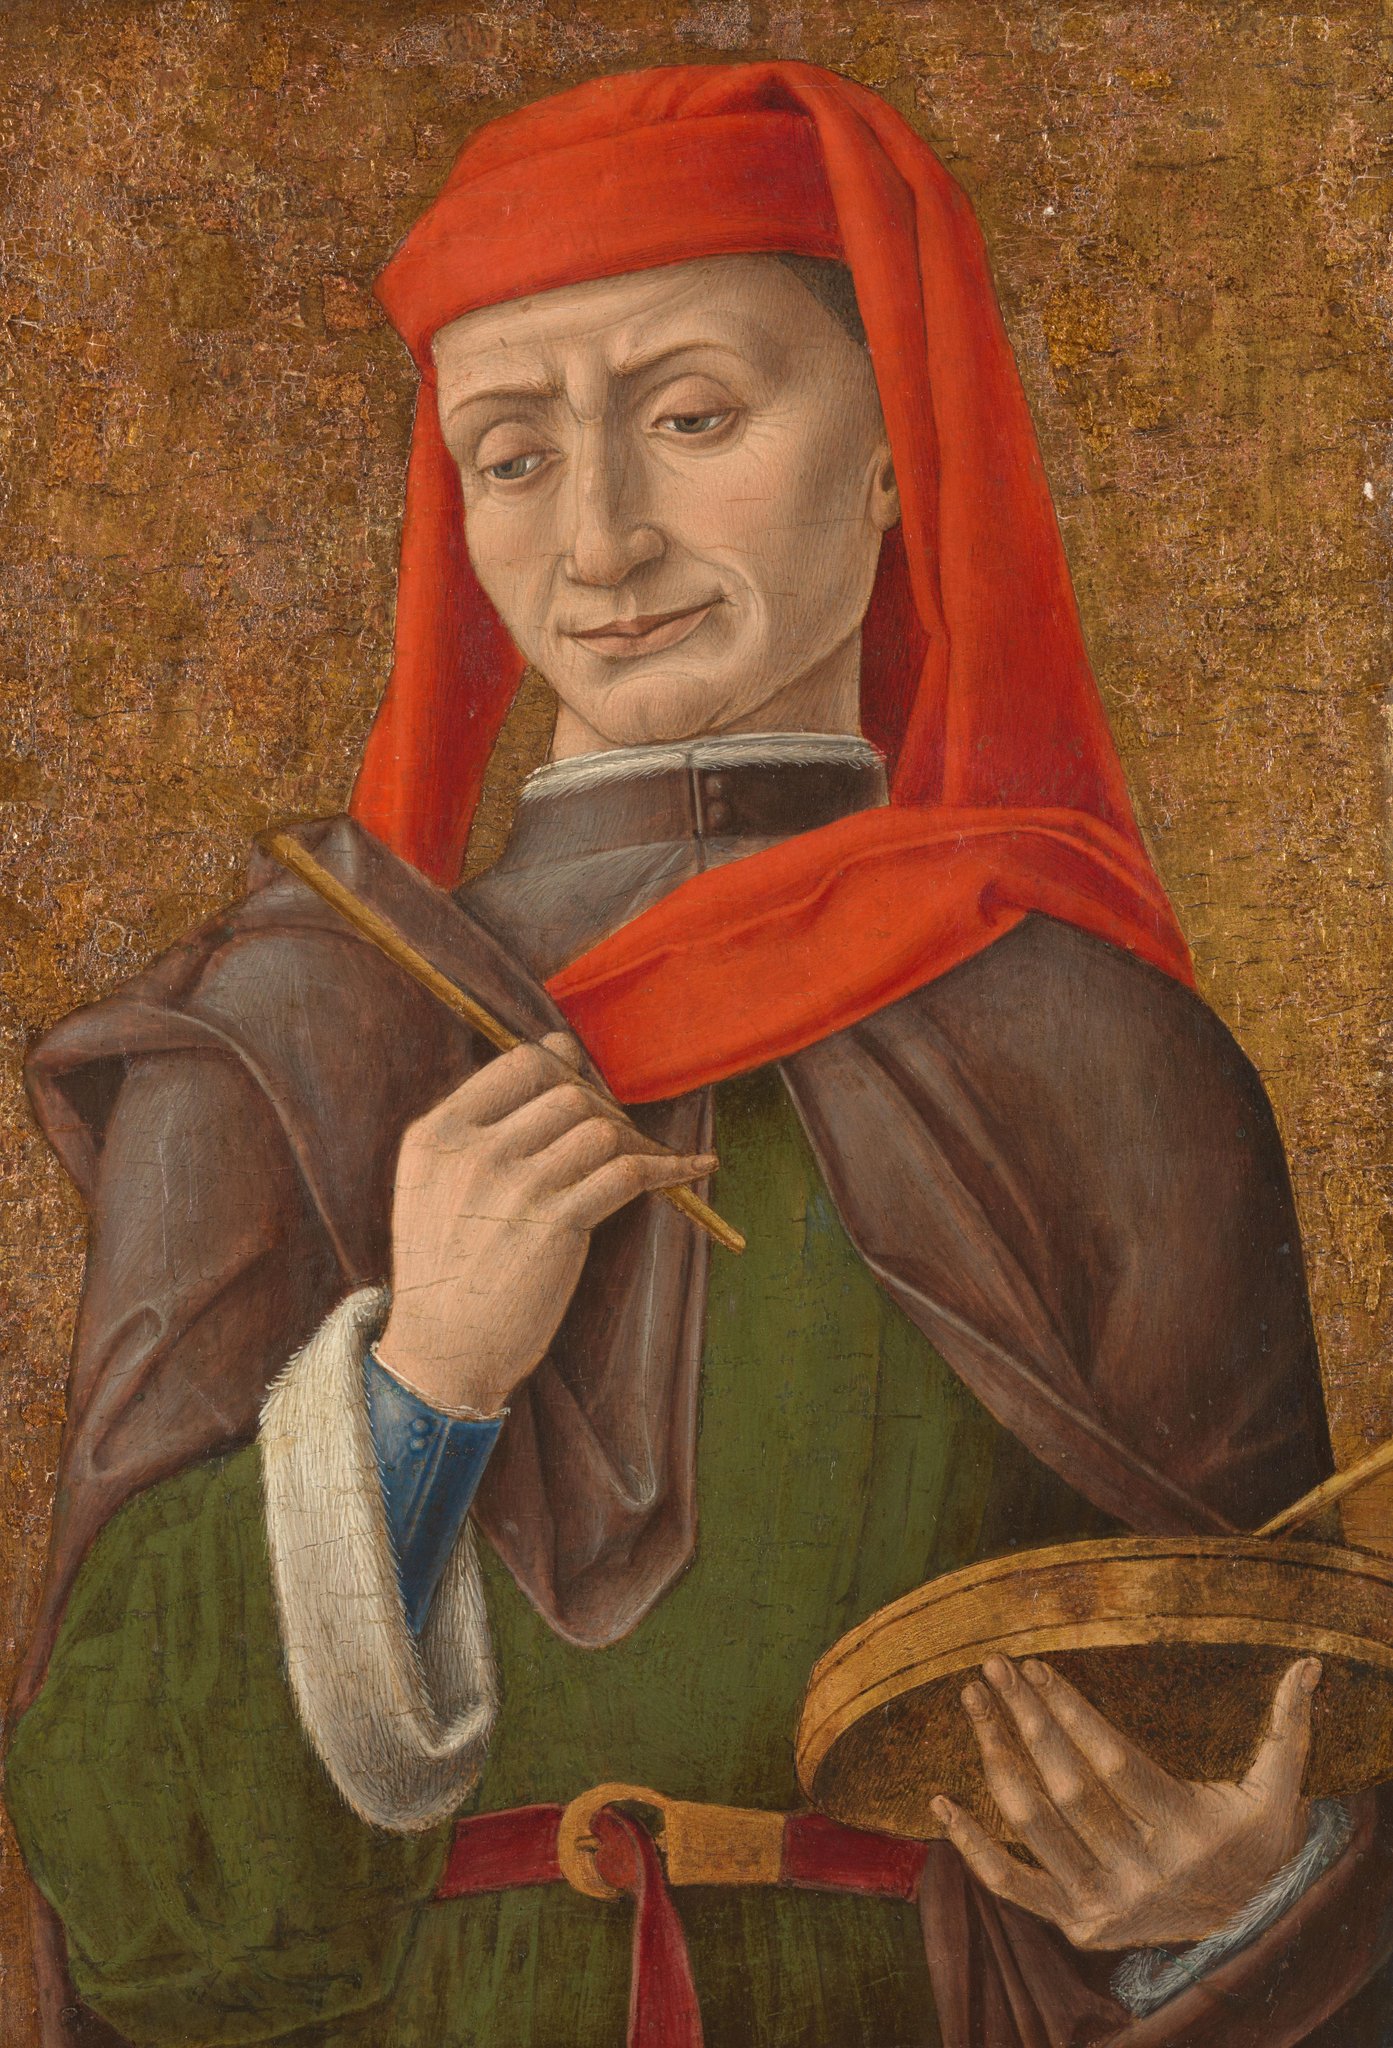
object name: painting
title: Saint Damian (or Cosmas)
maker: bartolommeo vivarini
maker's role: painter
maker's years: 1432-1499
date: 1465-1480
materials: panel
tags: the twin-brothers cosmas and damian(us), martyrs and physicians; possible attributes: box of ointment, cap, gown, lancet, pestle and mortar, urinal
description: Halffiguur van de heilige Damianus (of misschien Cosmas) in de hand een ronde zalfdoos. Pendant van SK-A-4235.